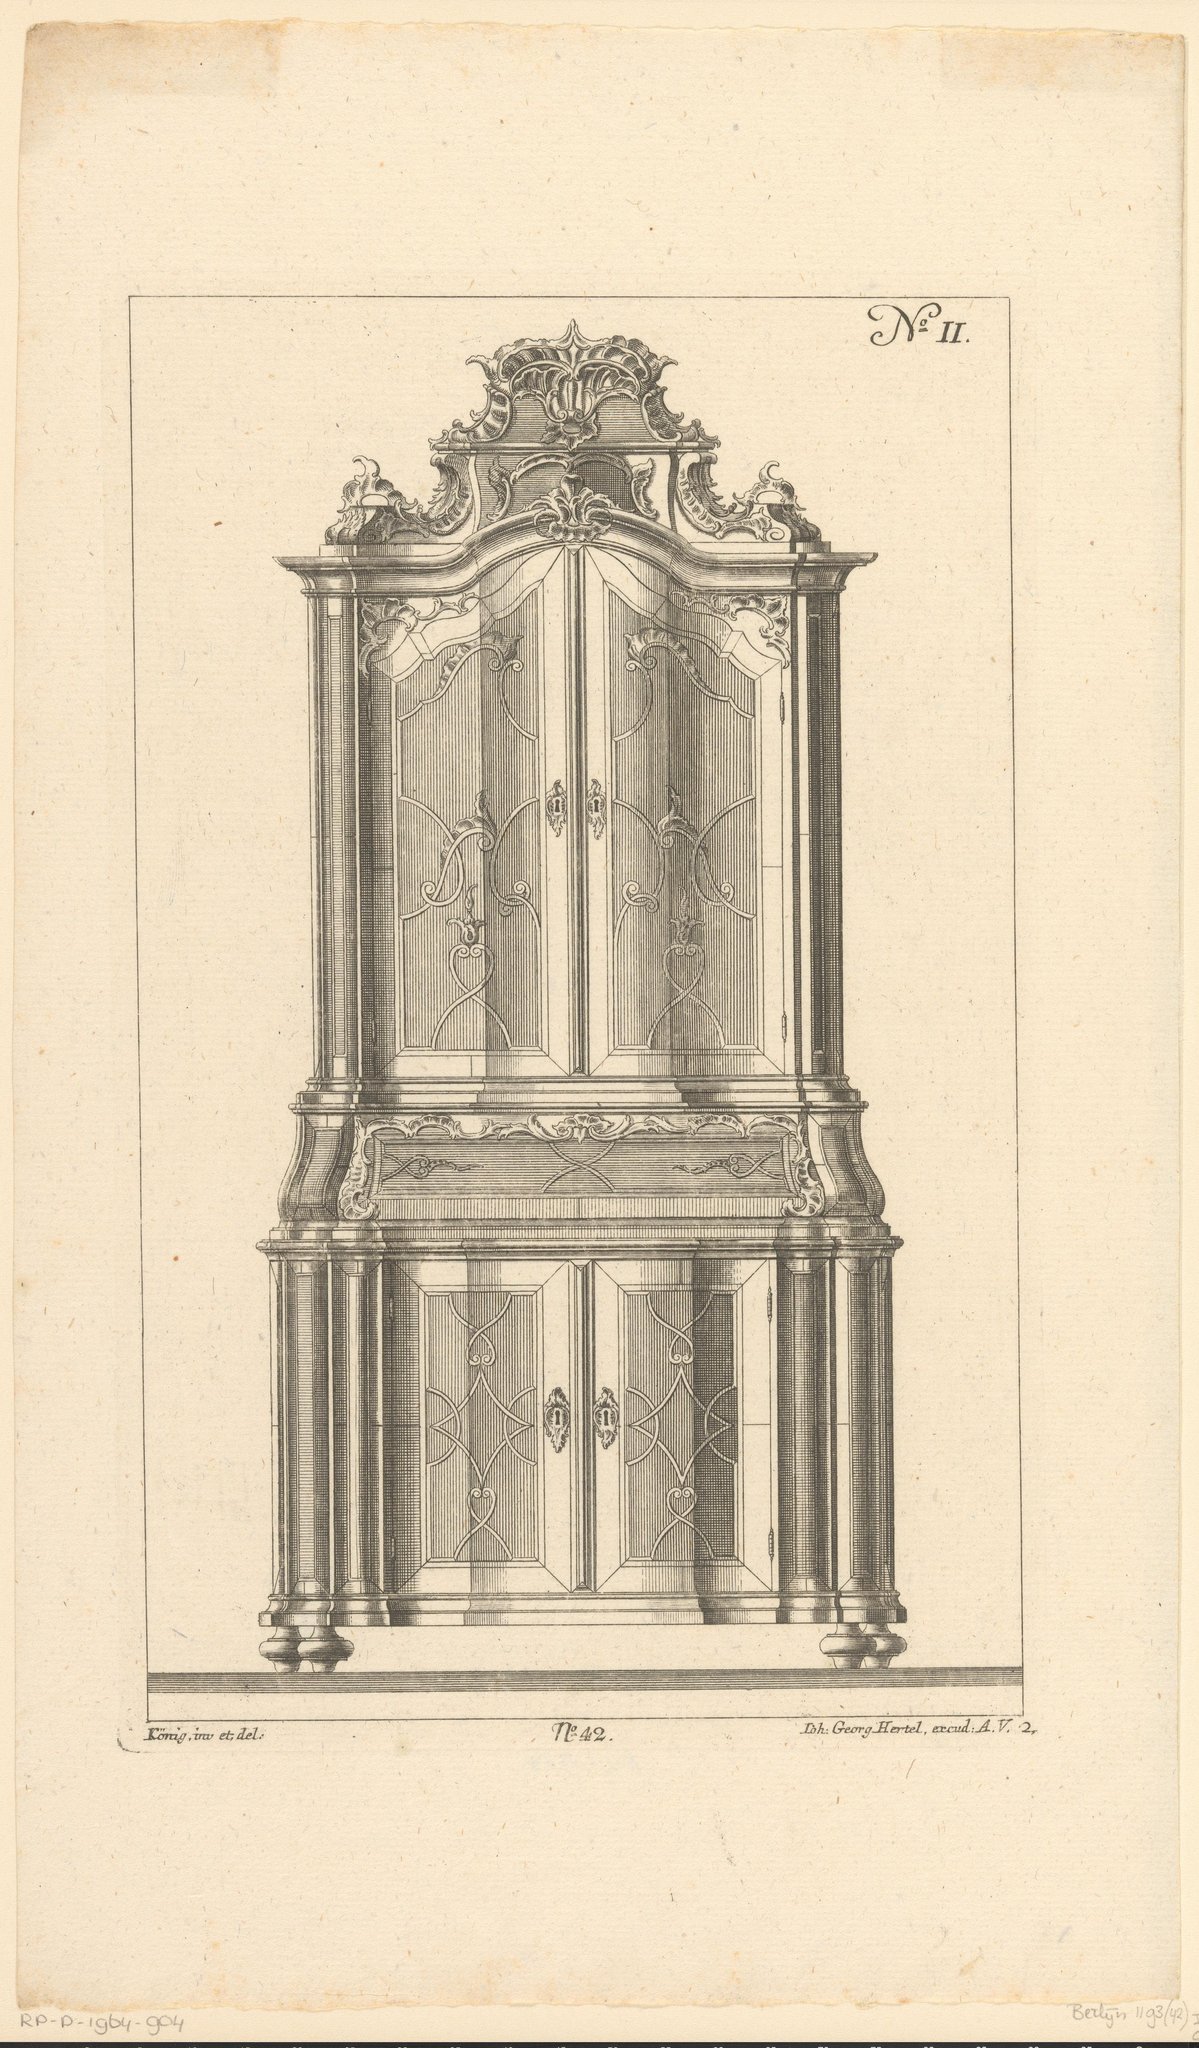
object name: ornament print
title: Kast met rocaille ornamenten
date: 1705-1775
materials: paper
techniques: engraving, etching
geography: augsburg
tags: ornamental cupboard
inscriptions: collector's mark: Lugt 2228, collector's mark: Lugt 2760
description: Ontwerp voor een kast met twee deuren onder en boven en een lade in het midden. Gedecoreerd met rocaille ornamenten. Uitgeversnummer 42.